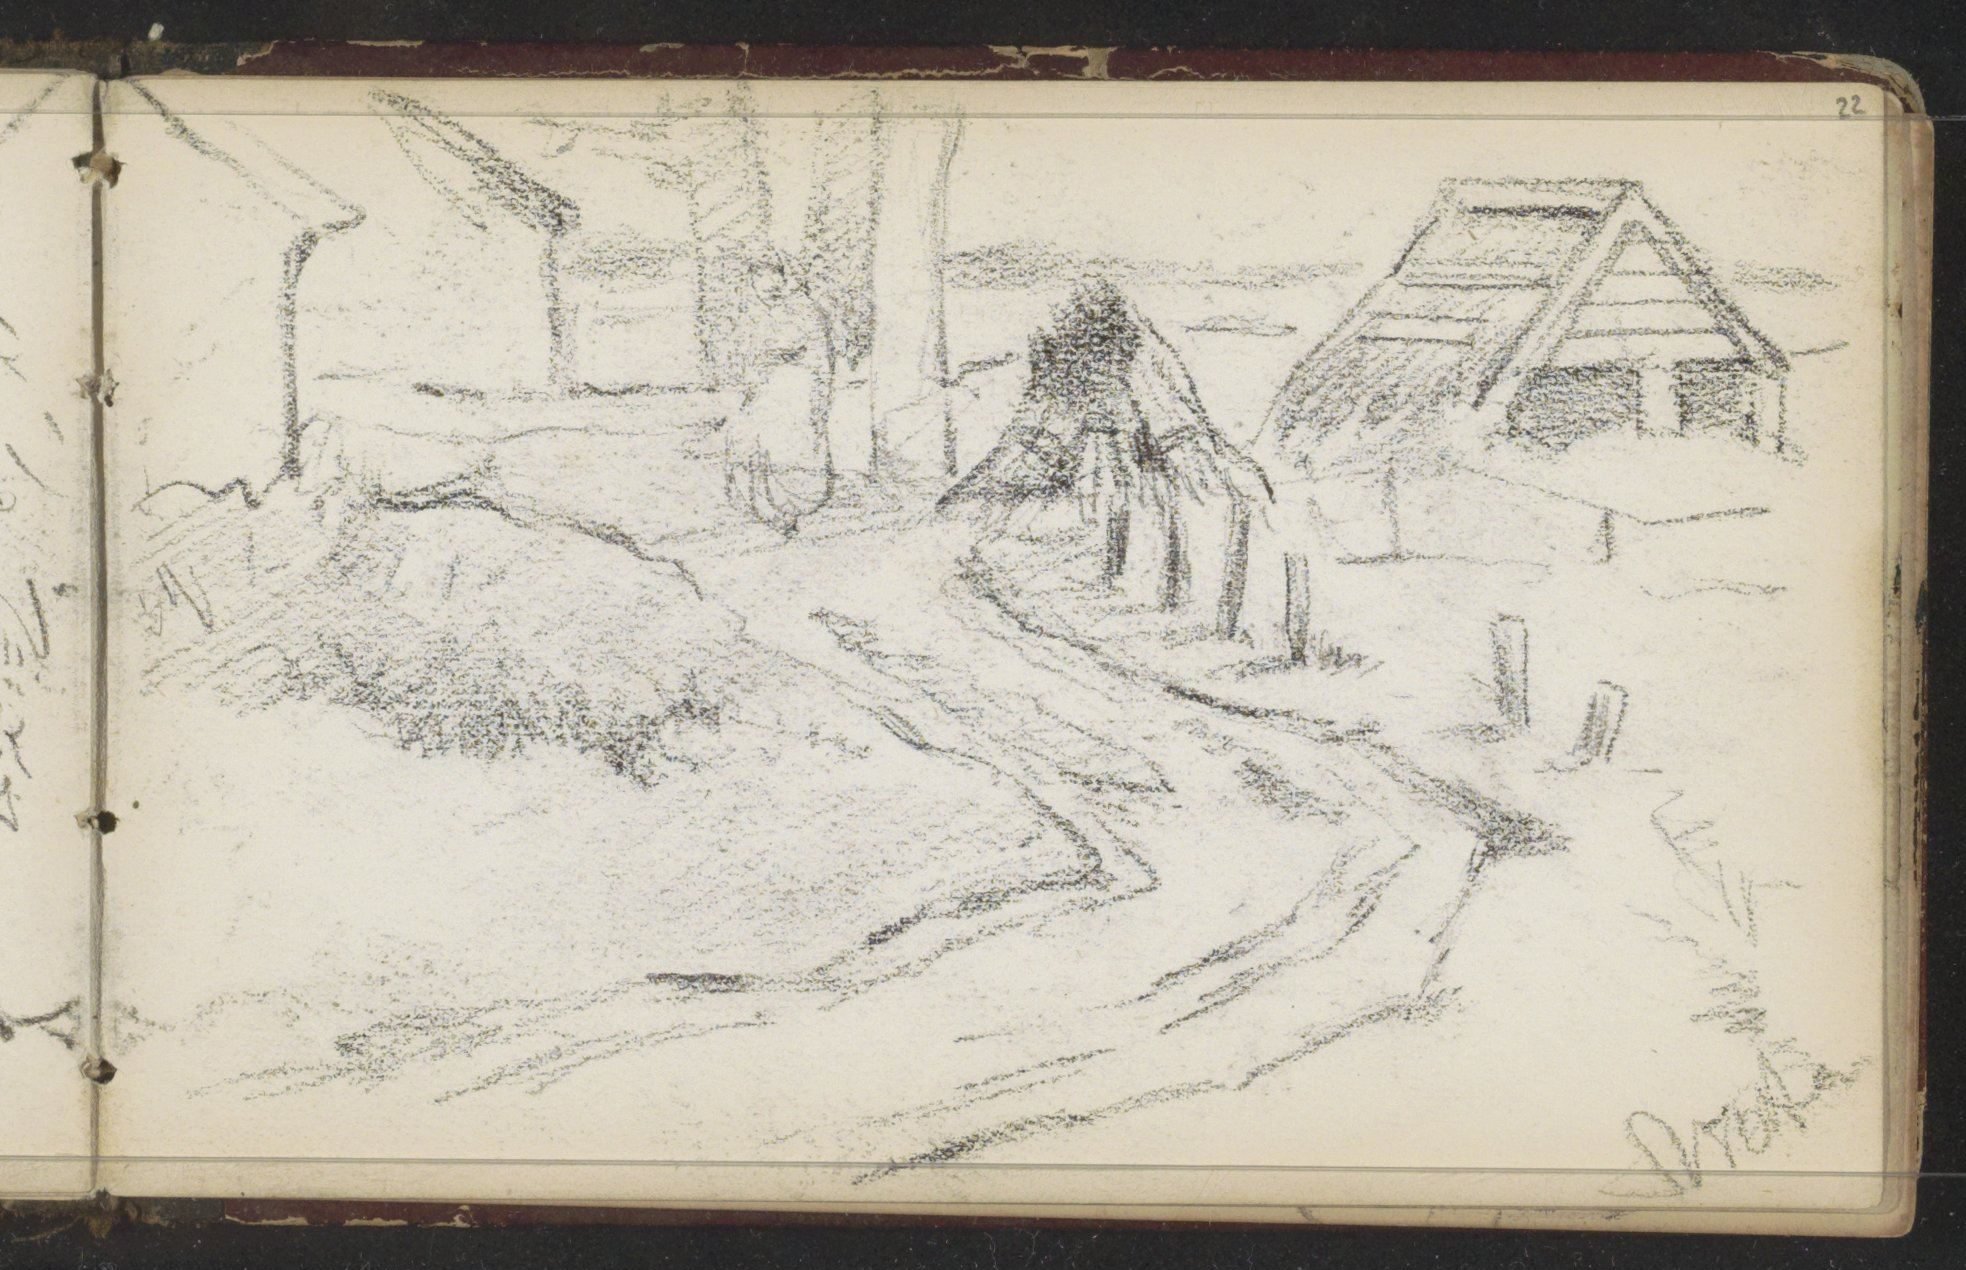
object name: sketchbook leaf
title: Pad langs een hut en korenschoven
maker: willem cornelis rip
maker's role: draughtsman, painter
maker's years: 1856-1922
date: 1891-1892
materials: chalk, paper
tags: road, path, sheaf, hut, cabin, lodge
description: Blad 22 recto uit een schetsboek met 28 bladen.